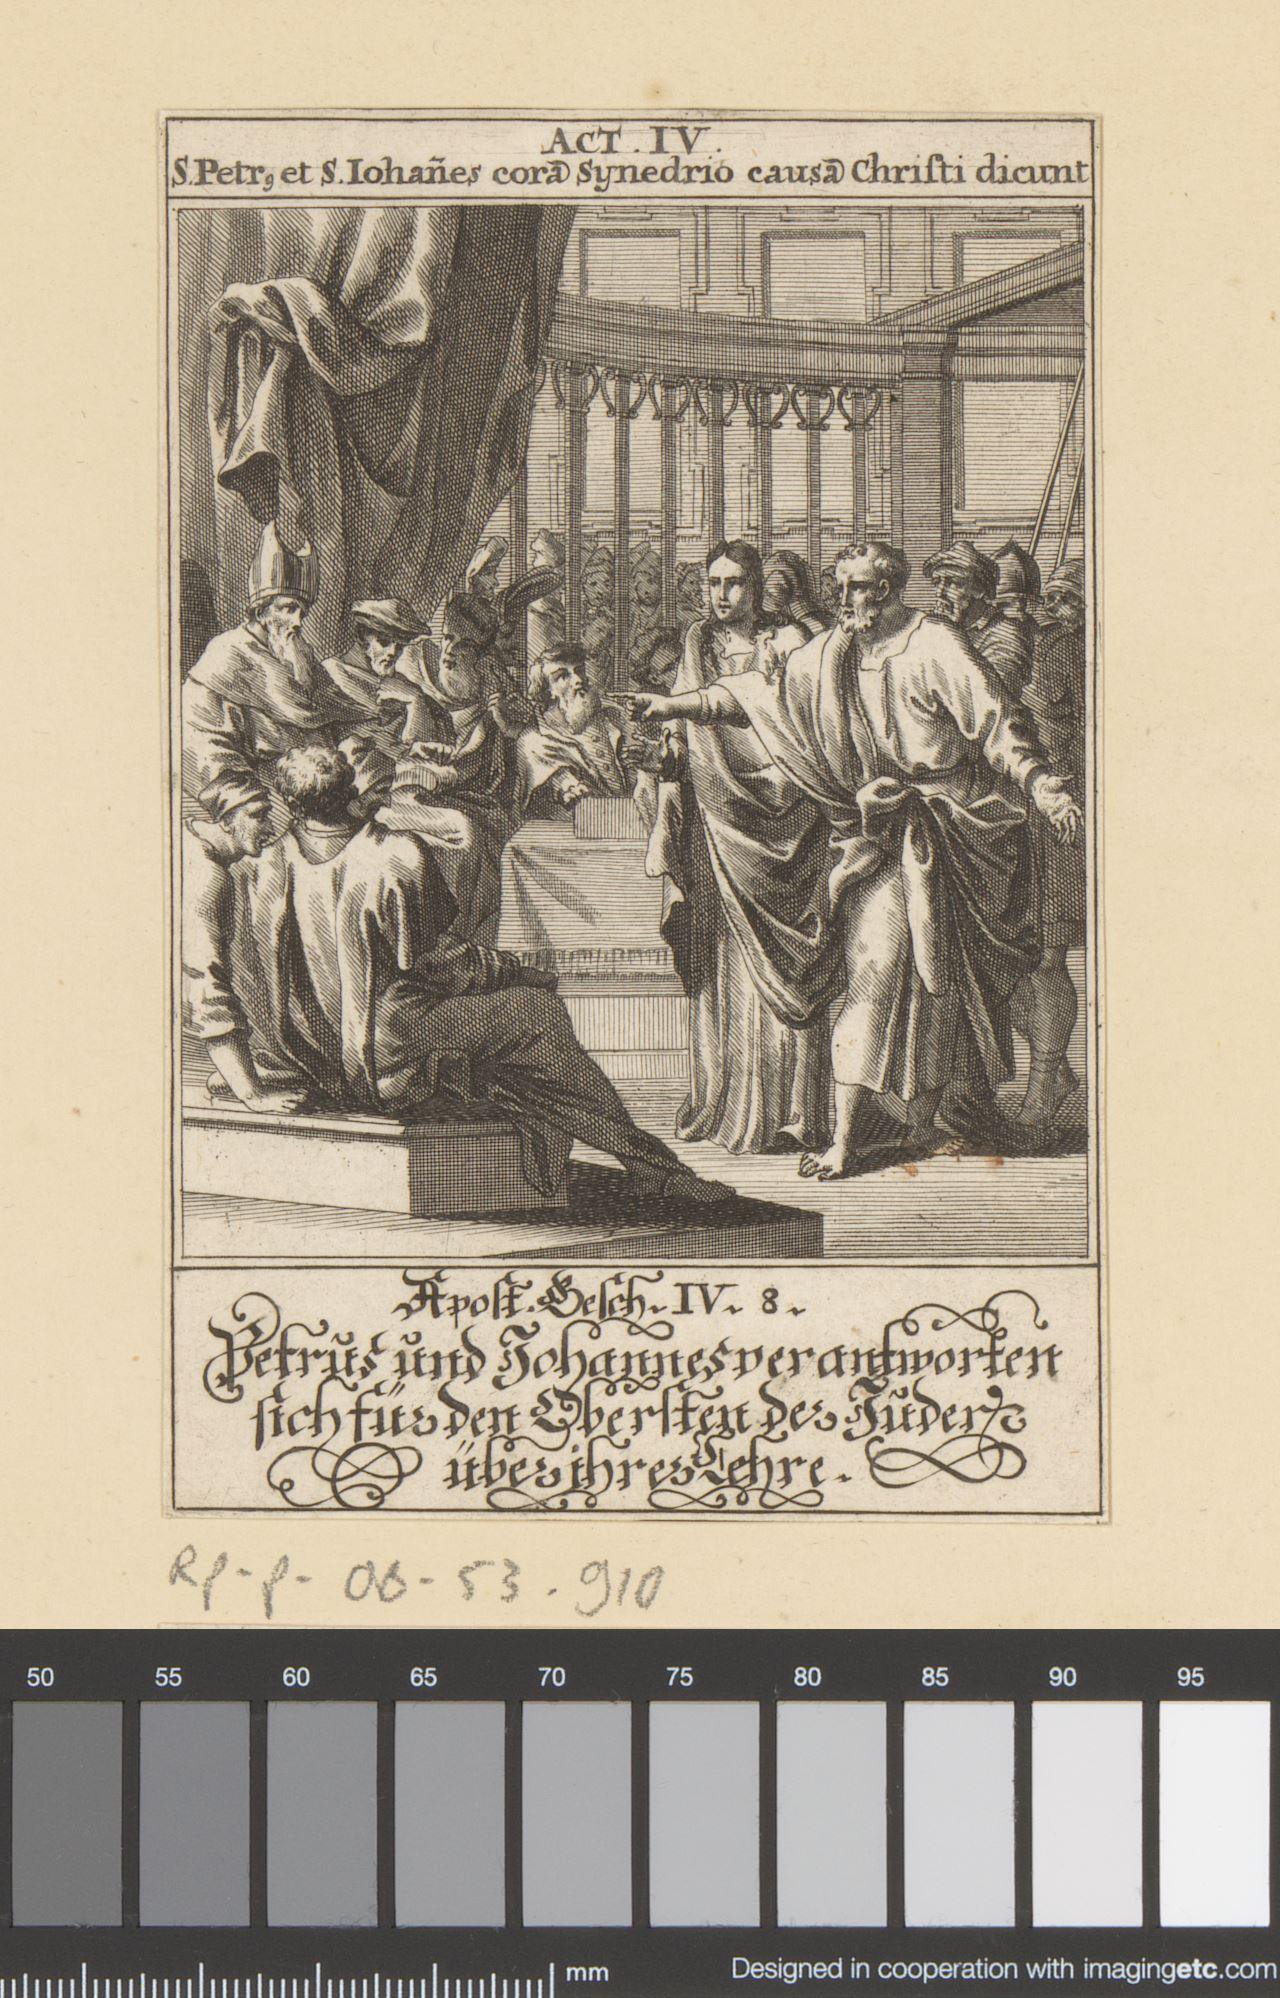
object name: print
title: Apostel Petrus en apostel Johannes verantwoorden zich over hun leer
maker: Anonymous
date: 1697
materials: paper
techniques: etching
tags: the high priest and sadducees have peter and the apostles put in prison (acts 5:17-42)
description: Prent ook gebruikt in: Biblia ectypa : Bildnussen auss Heiliger Schrifft. Regensburg: Chr. Wiegel, 1697.